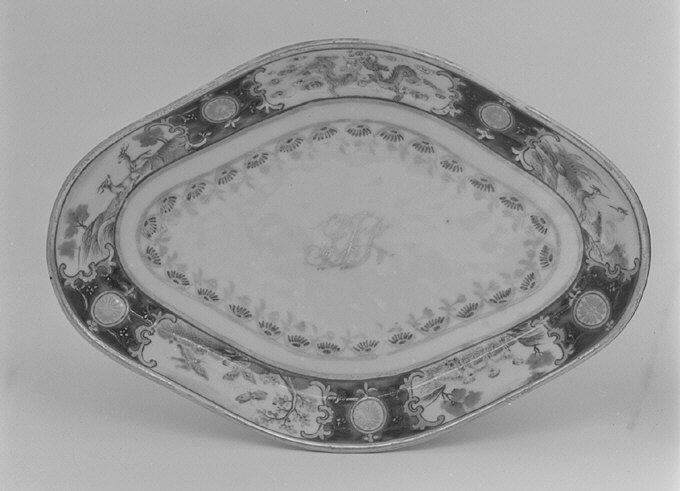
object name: sauceboat tray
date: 1801-1833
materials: hard paste porcelain